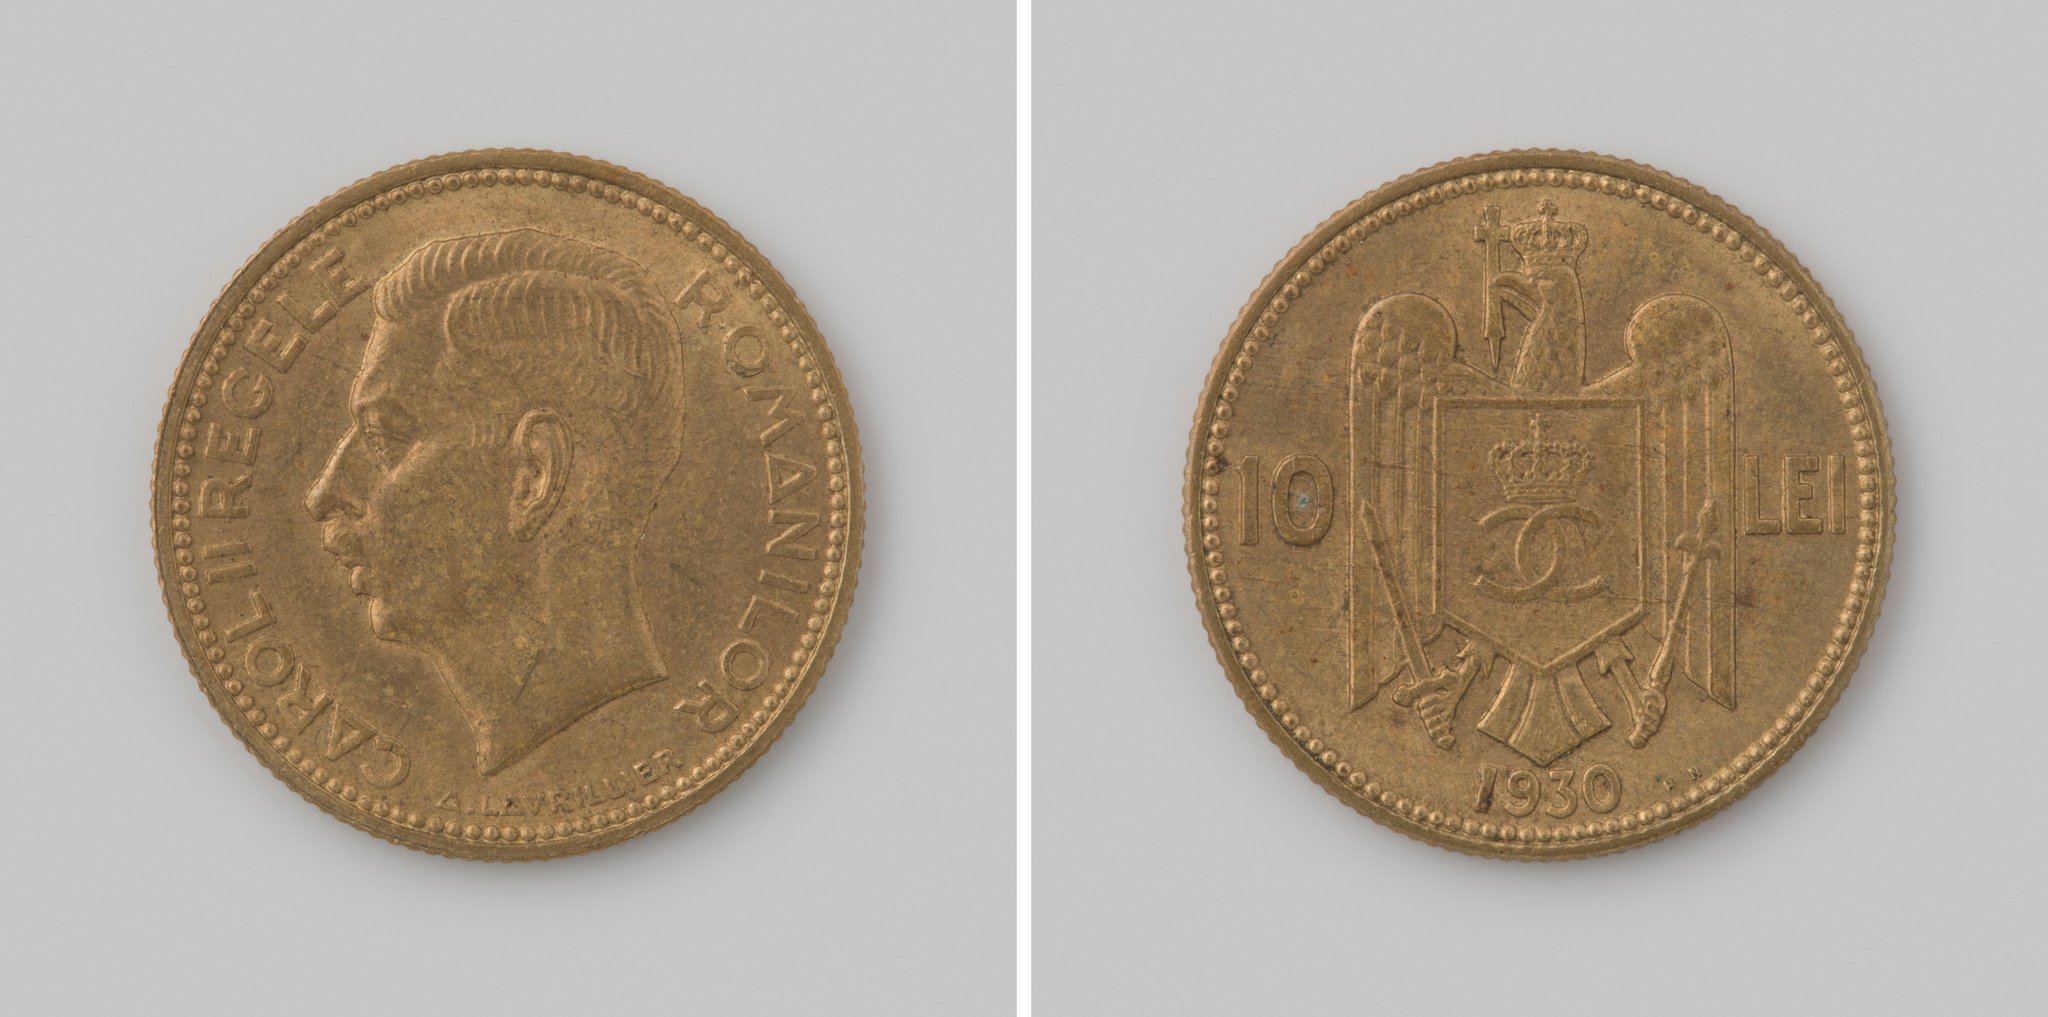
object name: coin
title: 10 lei uit Roemenië van koning Carol II, 1930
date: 1930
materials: brass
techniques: striking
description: Messing munt. Voorzijde: hoofd van de koning naar links. Keerzijde: tussen waarde-aanduiding adelaar met gespreide vleugels. In zijn bek een kruis en in zijn poten twee staven en op zijn bosrt een wapenschild, waarin twee ineengestrengelde letters C. Onderaan jaartal. Kartelrand.